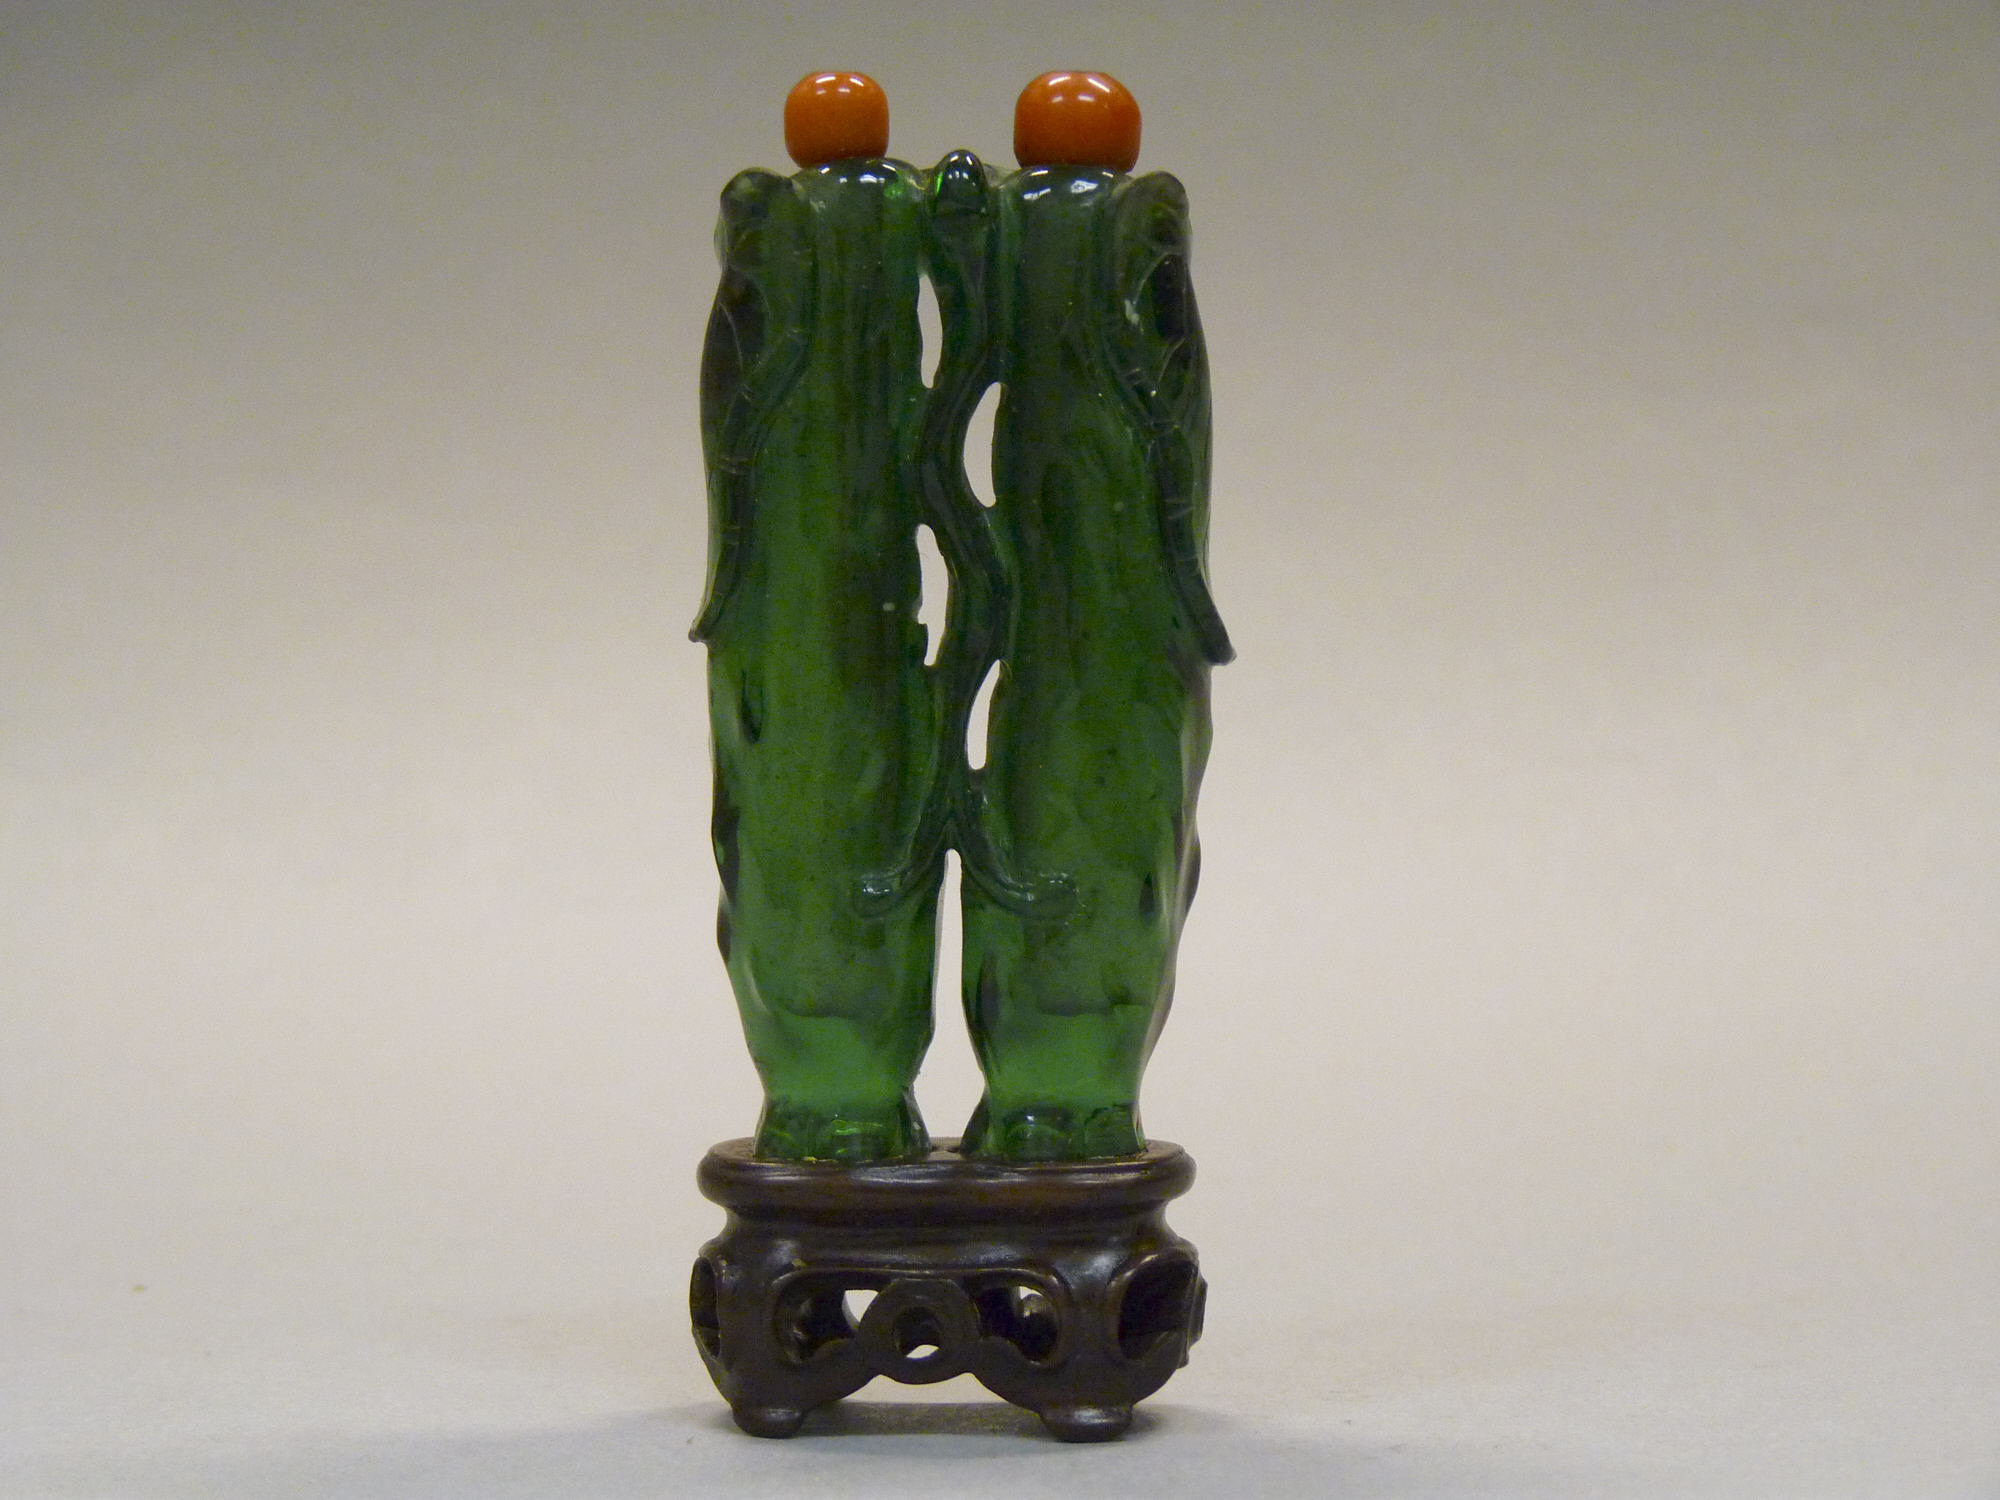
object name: snuff bottle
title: Twin Snuff Bottles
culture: chinese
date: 1801-1900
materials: glass